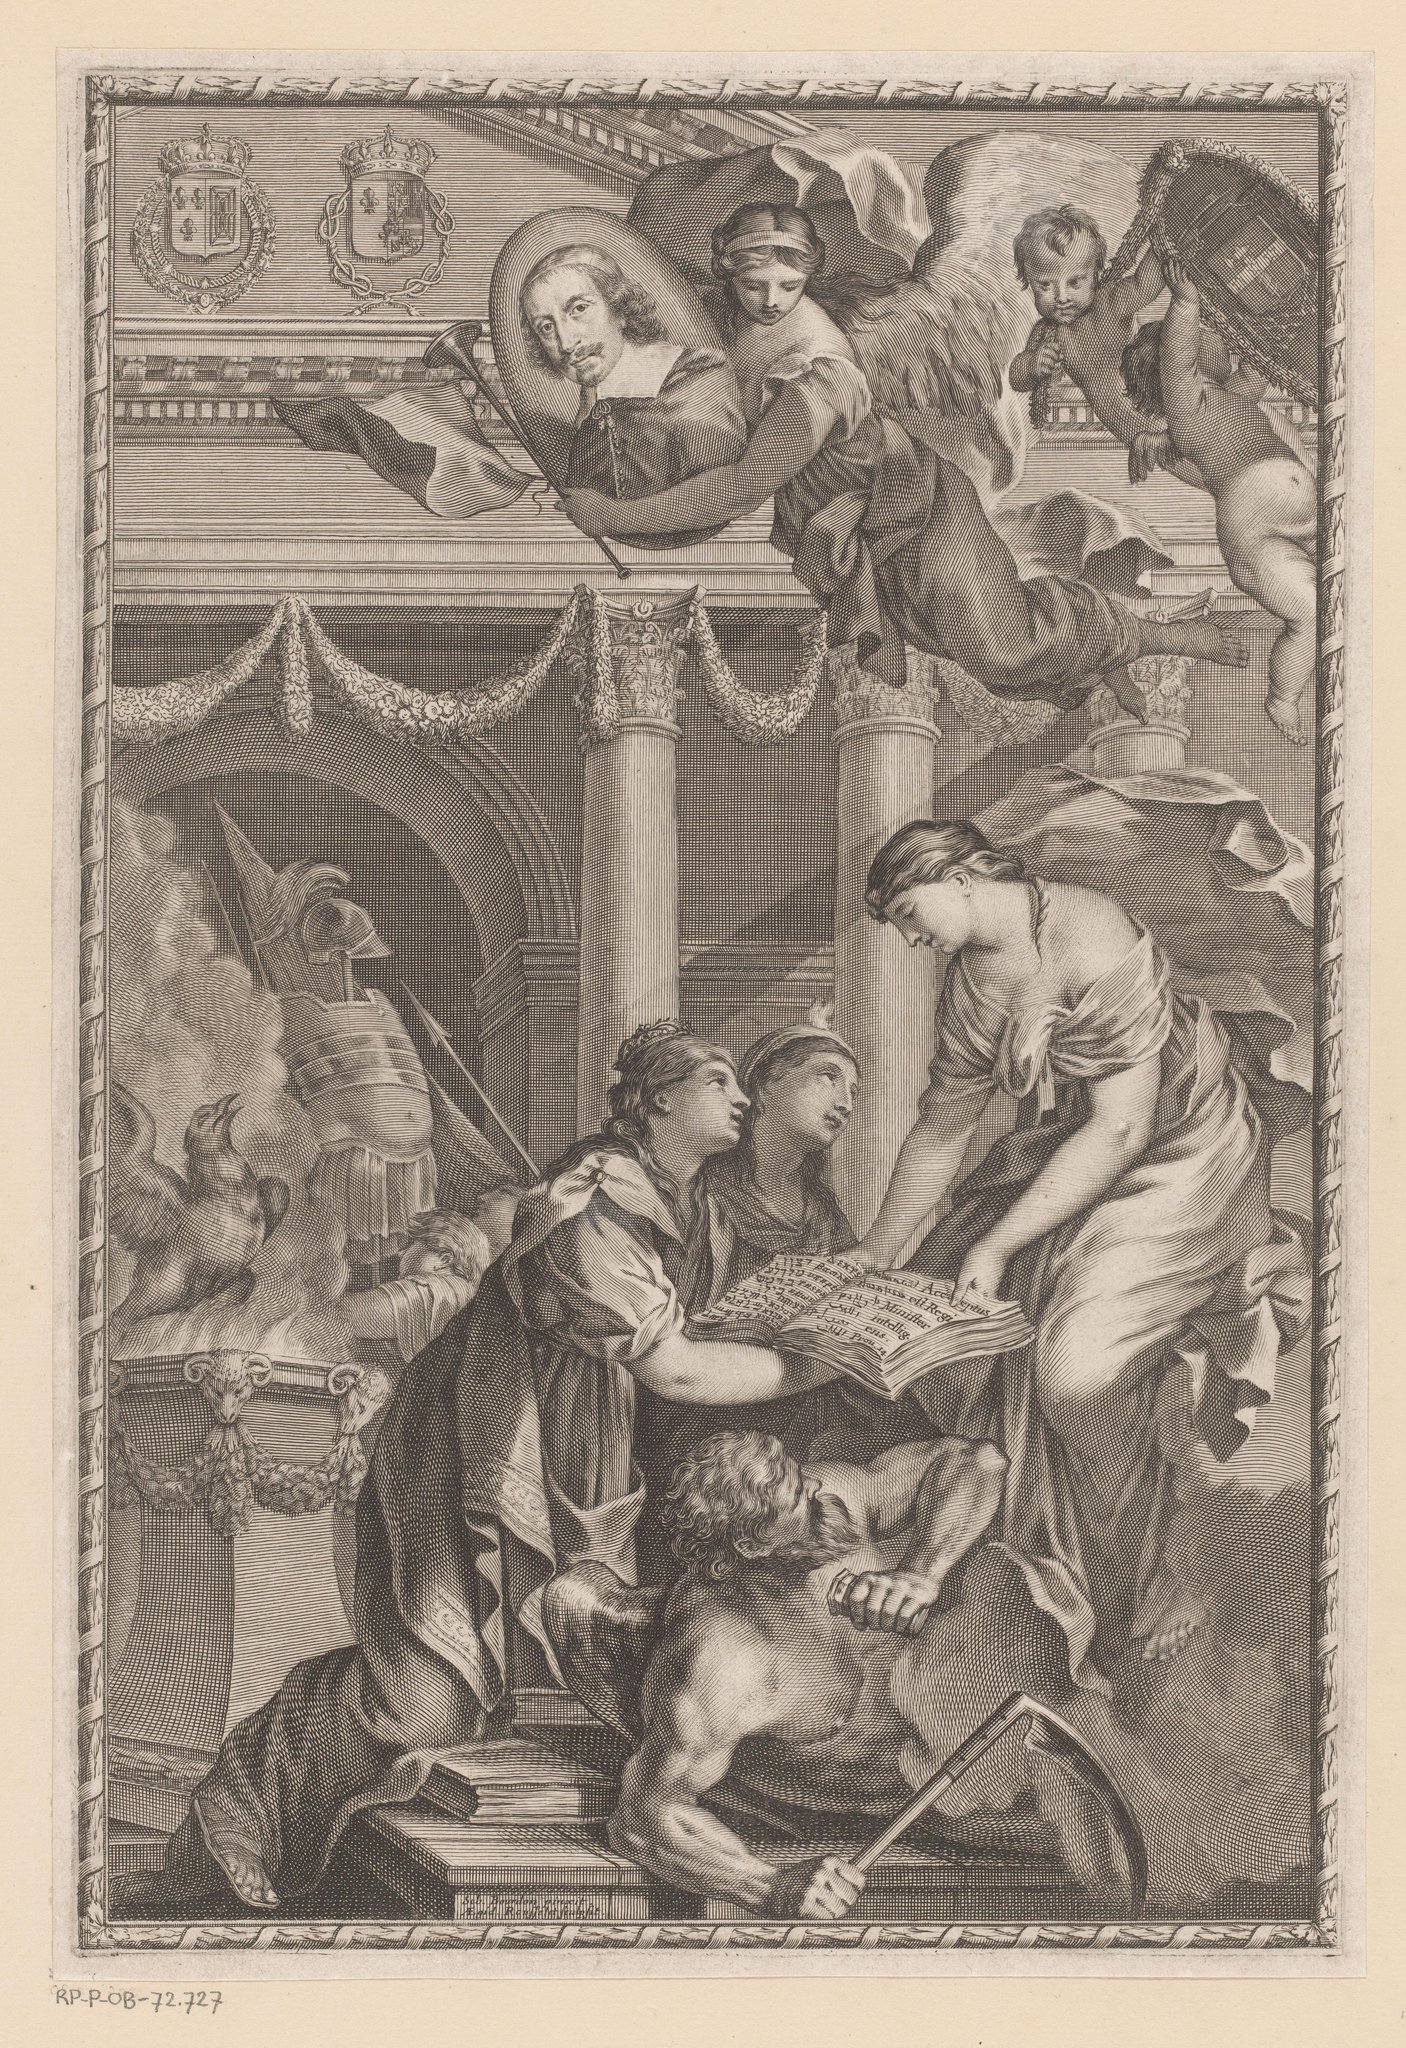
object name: print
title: Drie vrouwen met een boek waaronder Tijd ligt, erboven zweeft Fama met een portret van kardinaal Mazarin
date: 1620-1686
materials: paper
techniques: engraving, etching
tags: jules mazarin, cardinal, historical persons, fame; 'fama', 'fama buona', 'fama chiara' (ripa), father time, man with wings and scythe, fabulous animals ~ birds: phoenix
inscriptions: collector's mark: Lugt 240